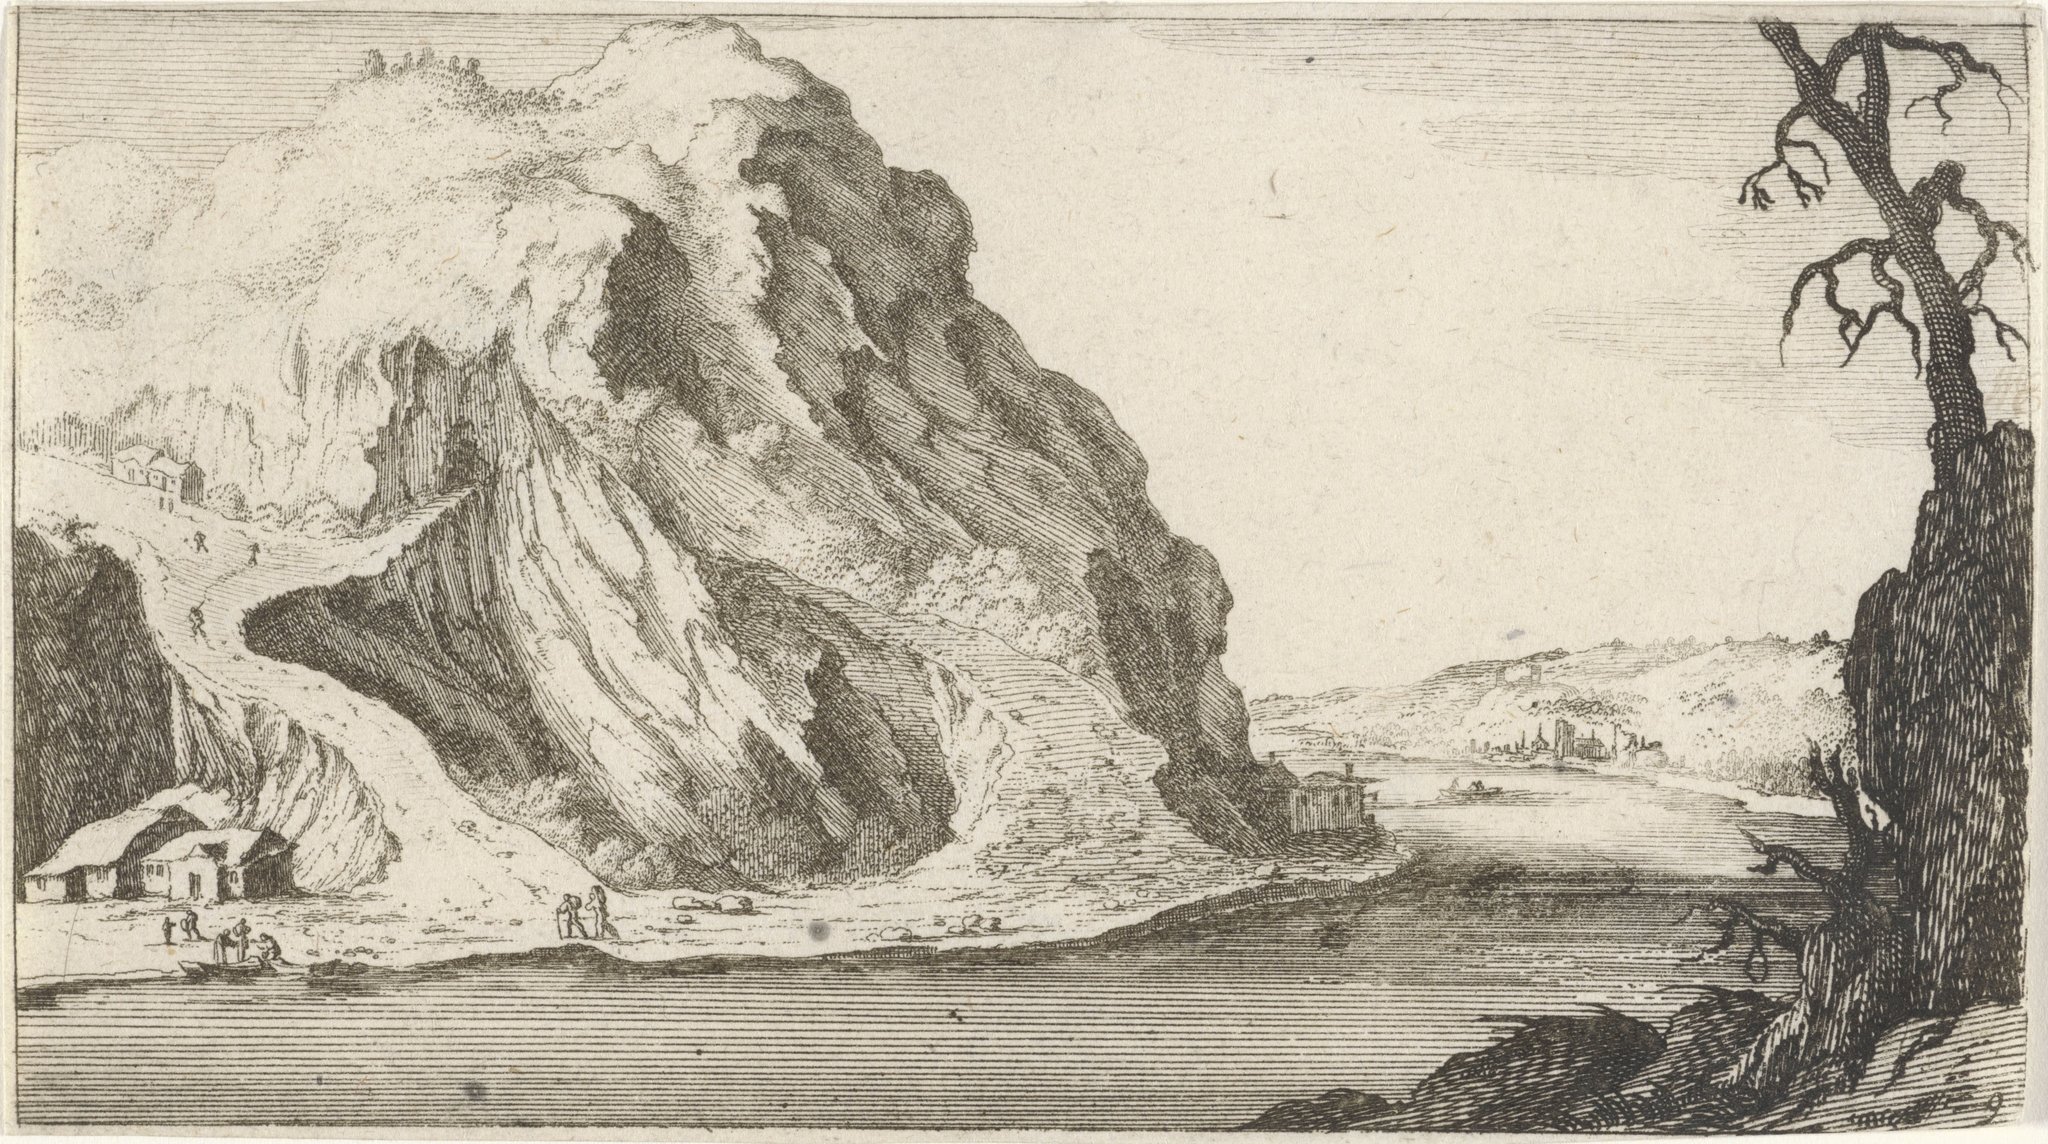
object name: print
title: Rivier in de bergen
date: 1640-1706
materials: paper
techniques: etching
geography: amsterdam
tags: river, mountains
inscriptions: collector's mark: Lugt 2228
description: Gezicht op een landschap met een berg waar een brede rivier langs stroomt. Aan de waterkant verschillende figuren. De prent maakt deel uit van een serie van twaalf landschappen.